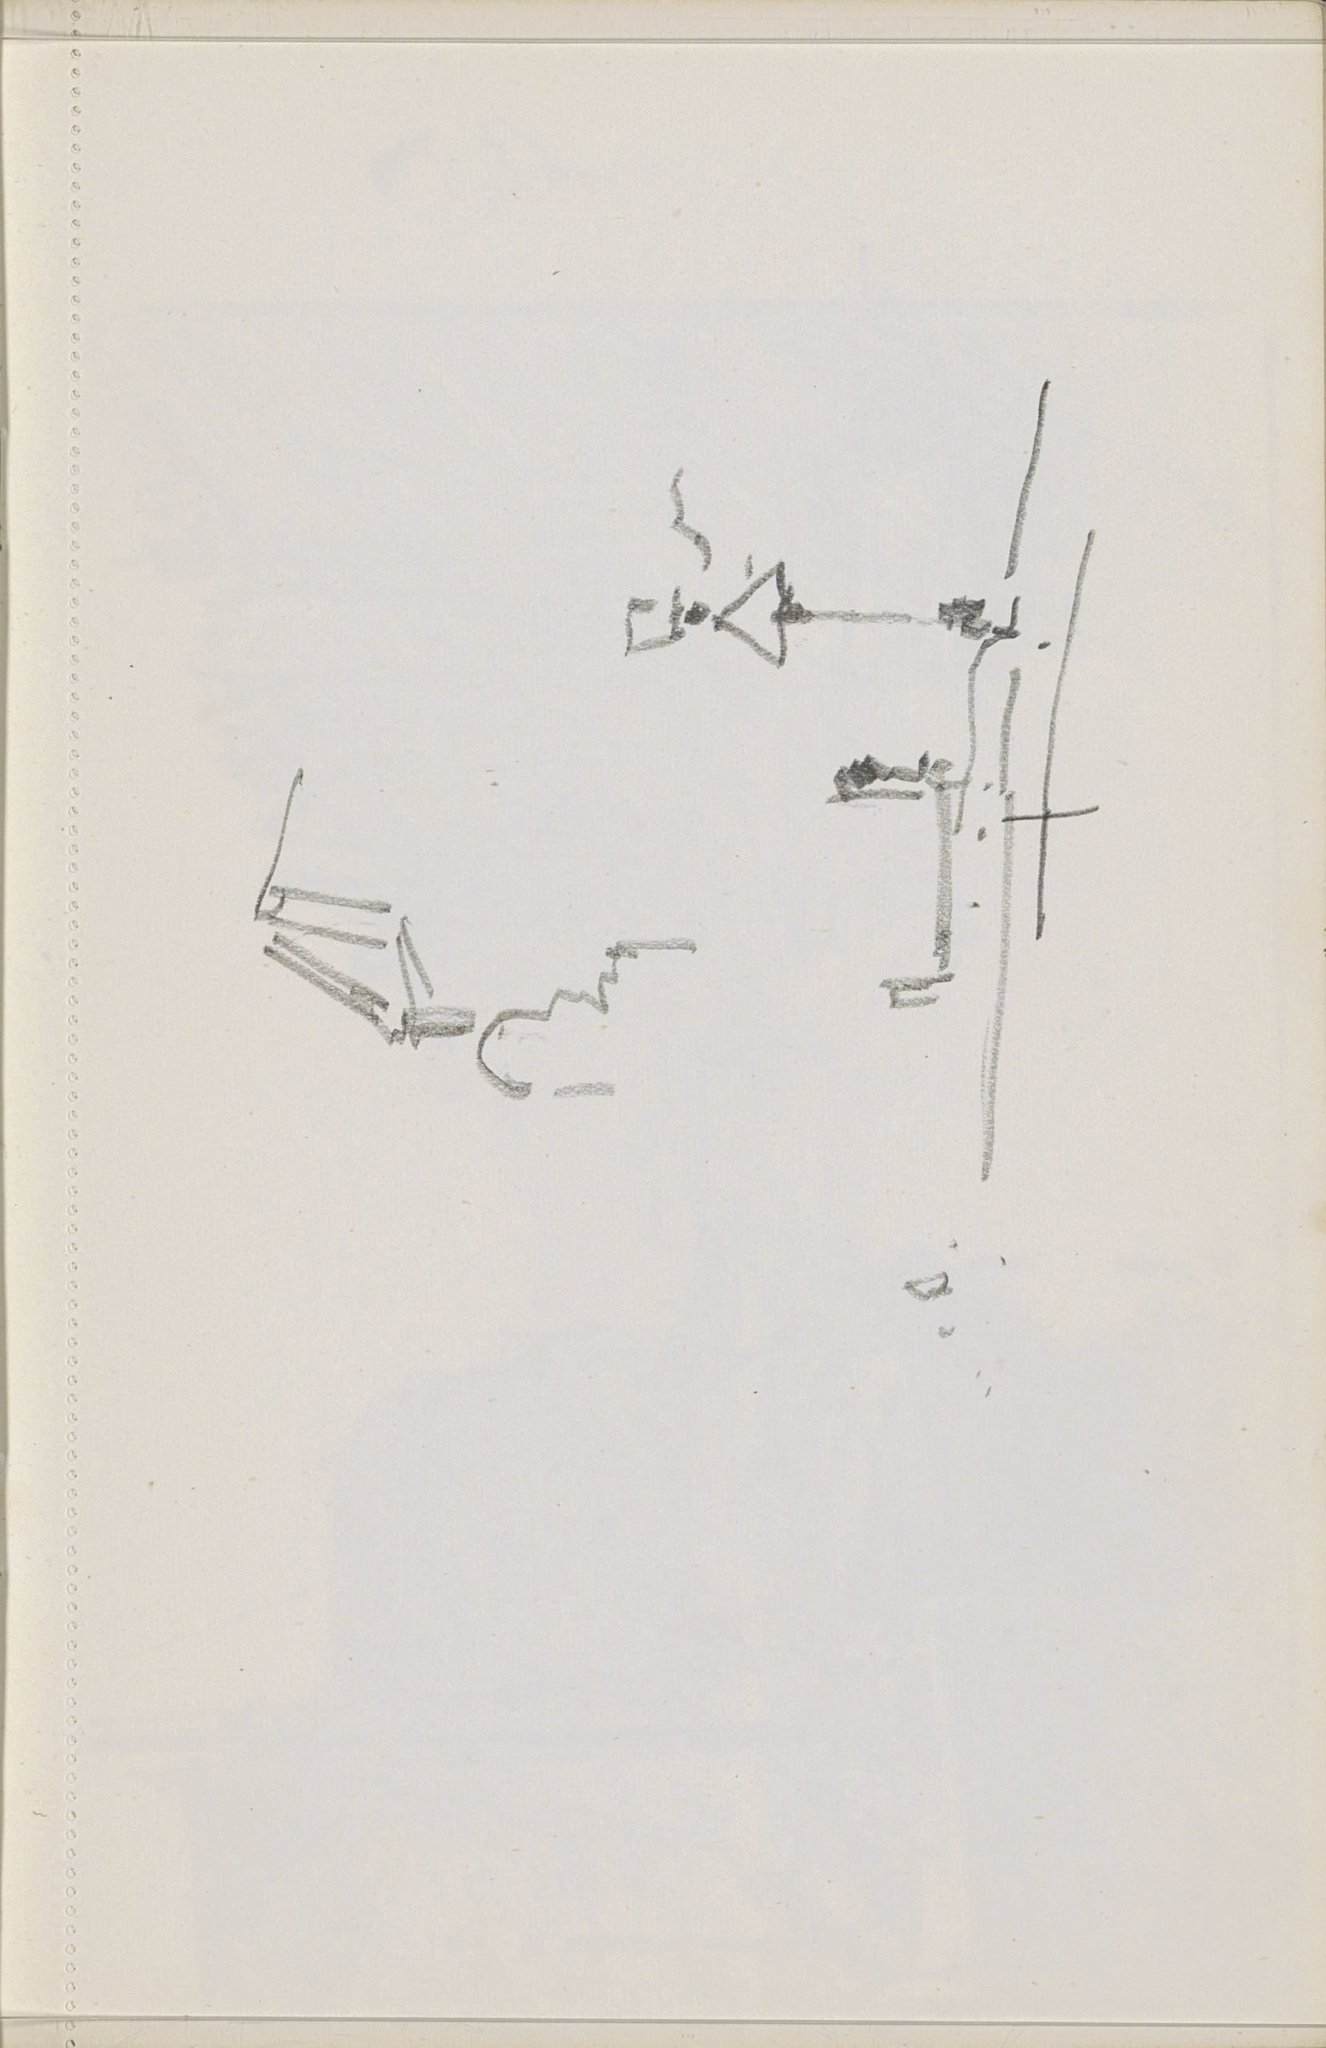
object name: sketchbook leaf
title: Straatlantaarn aan een weg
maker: cornelis vreedenburgh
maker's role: draughtsman, print maker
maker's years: 1880-1946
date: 1890-1946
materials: paper, pencil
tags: street lighting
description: Blad 36 recto uit een schetsboek met 53 bladen.